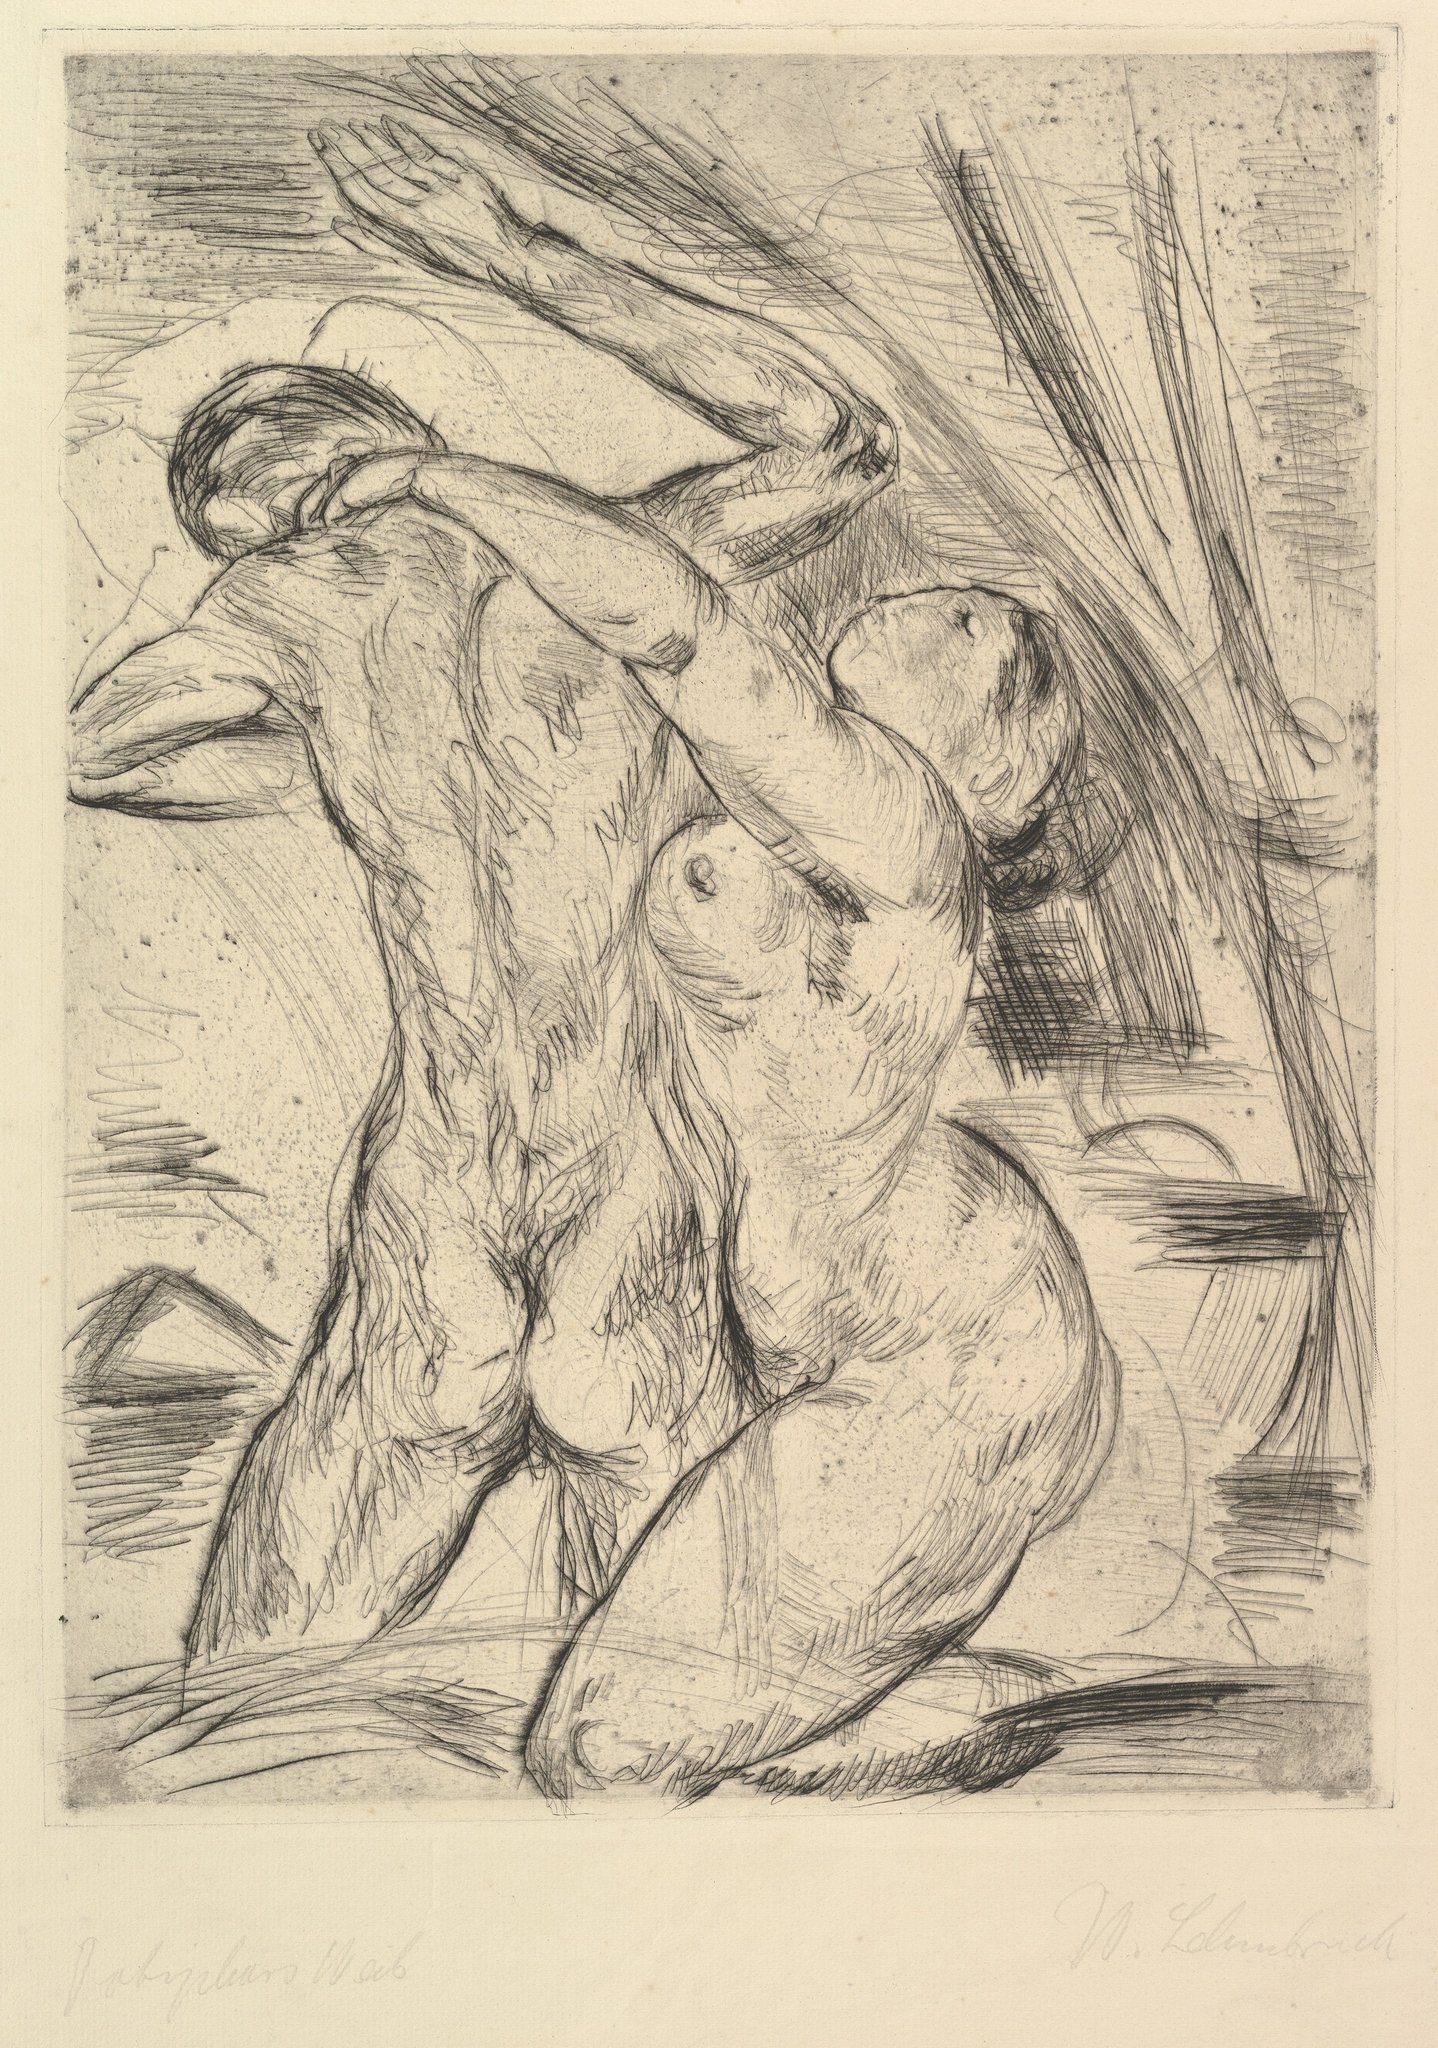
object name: print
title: Potiphar's Wife (Potiphars Weib)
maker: wilhelm lehmbruck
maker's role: artist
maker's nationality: german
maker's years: 1881-1919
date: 1914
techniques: drypoint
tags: male nudes,female nudes